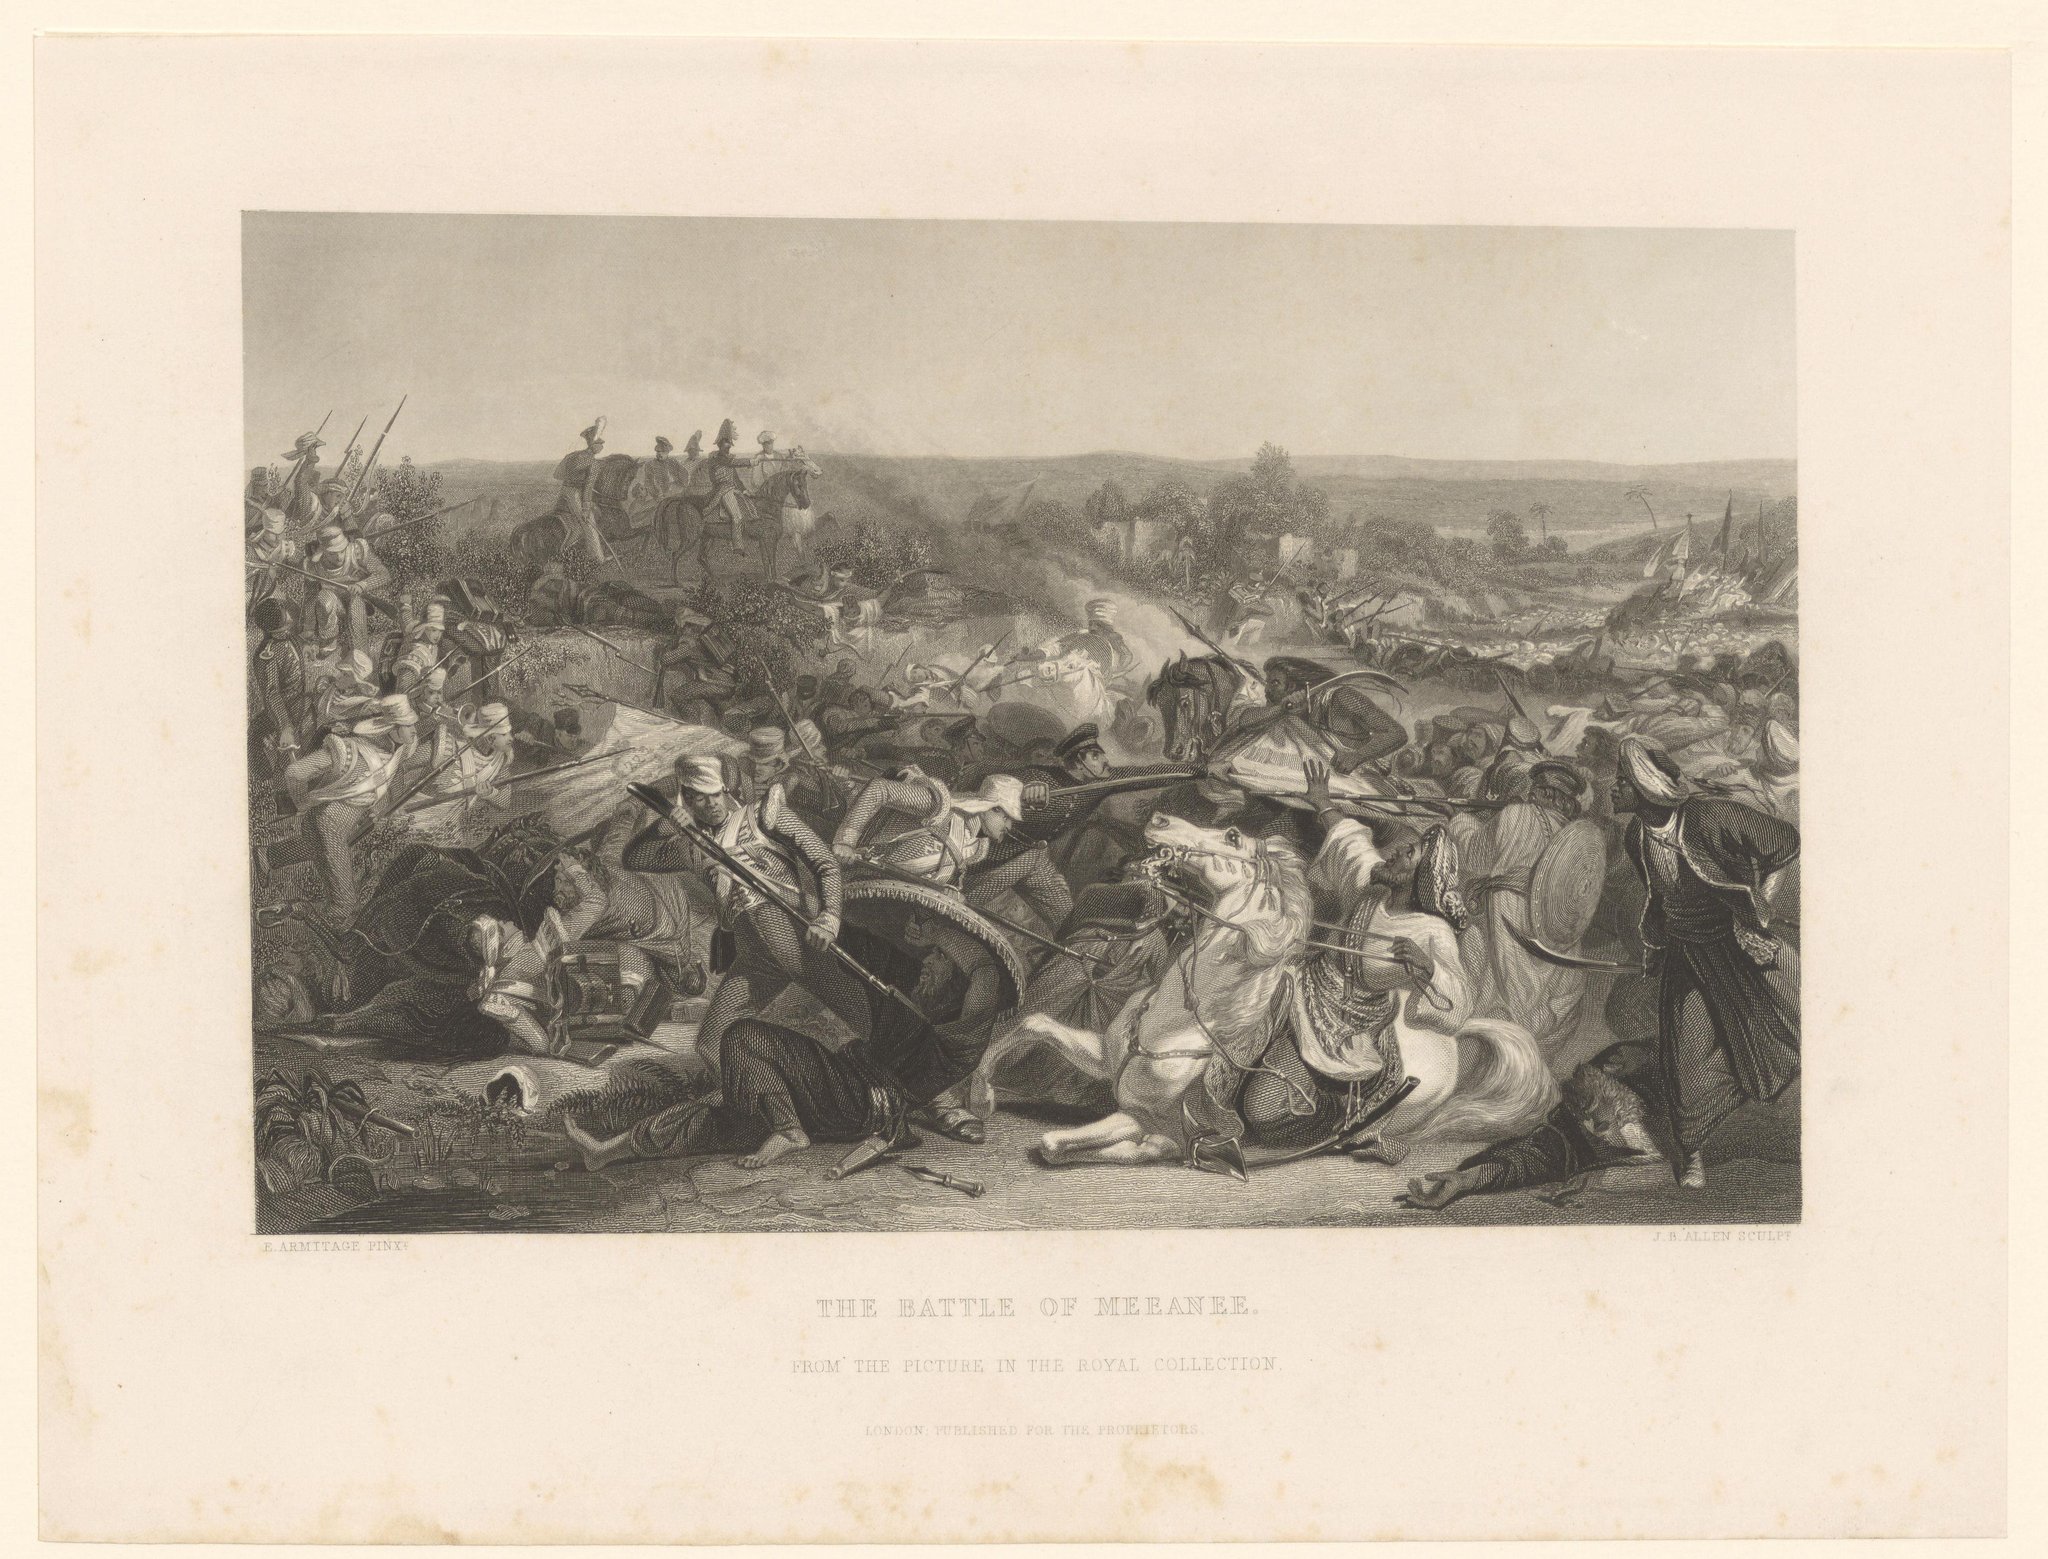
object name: print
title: Slag van Miani, 1843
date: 1855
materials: paper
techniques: engraving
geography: england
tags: battle (+ land forces)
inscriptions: collector's mark: Lugt 2228